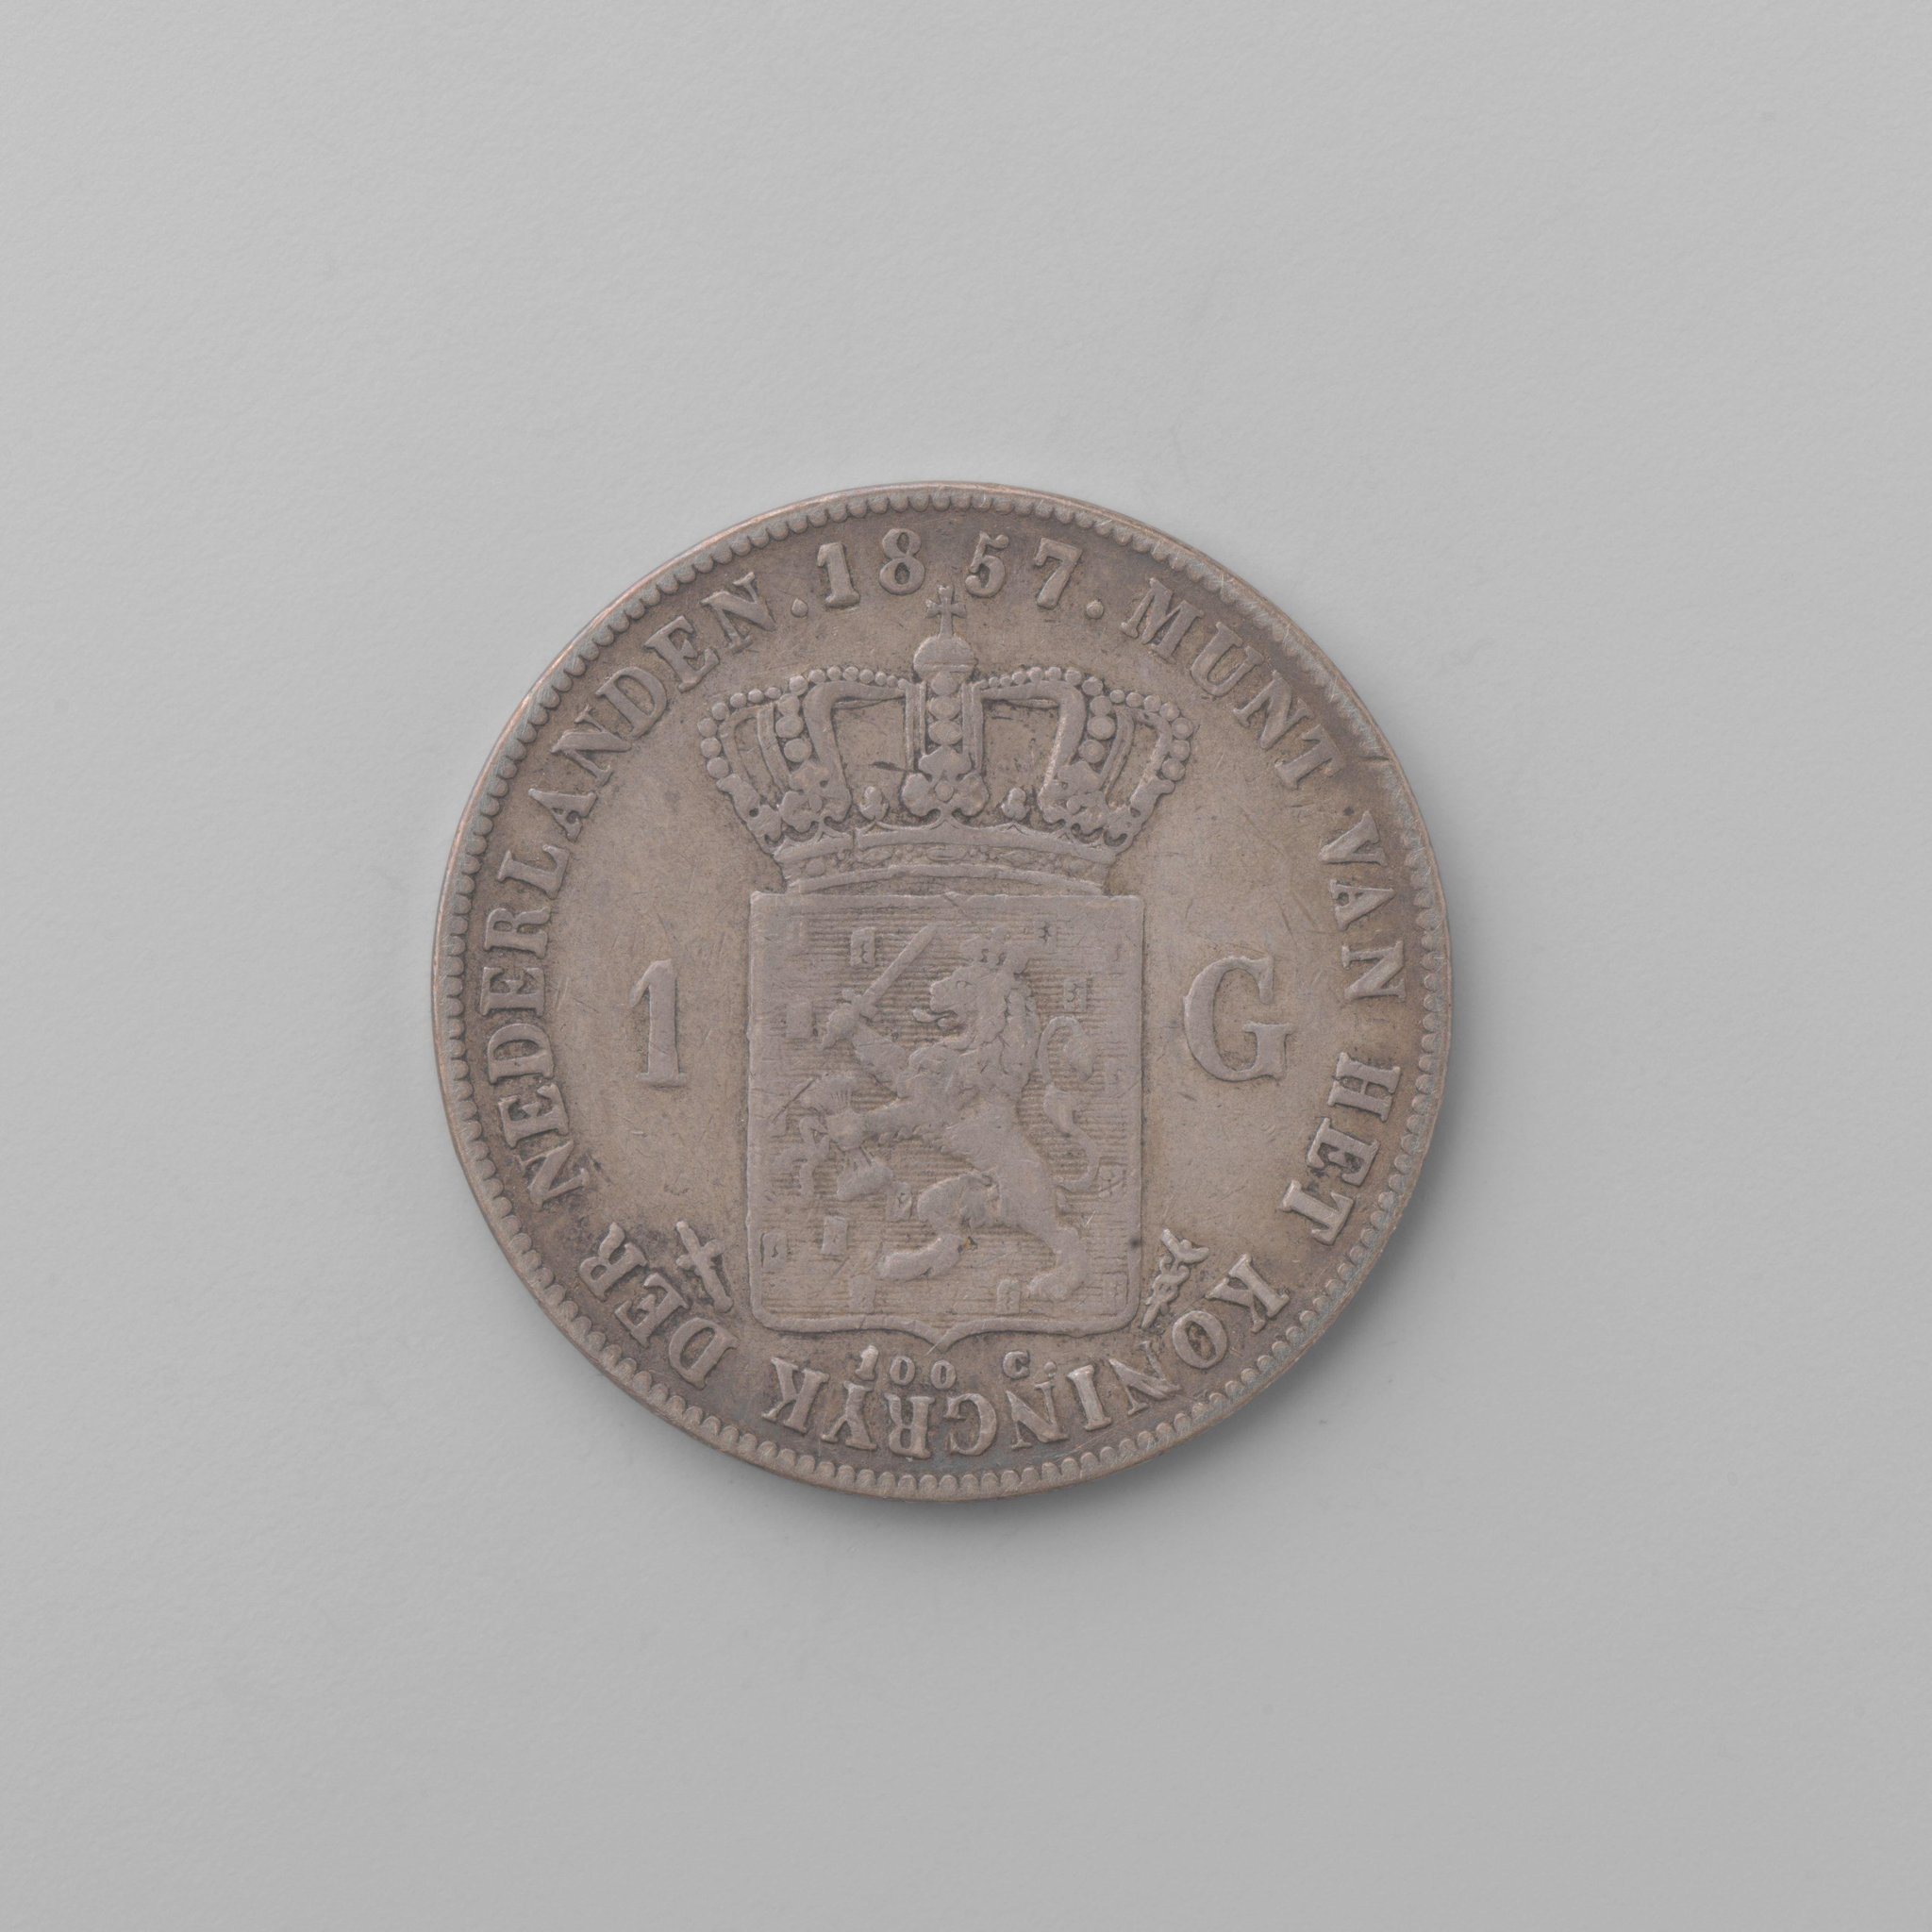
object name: coin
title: Nederlandse gulden, 1857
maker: willem iii (koning der nederlanden)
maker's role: koning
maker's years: 1817-1890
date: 1857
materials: silver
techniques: striking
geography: utrecht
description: Zilveren munt. Voorzijde: borstbeeld naar rechts. Keerzijde: tussen waarde-aanduiding 1 G gekroond rijkswapenschild. Jaartal boven kroon. Randschrift.